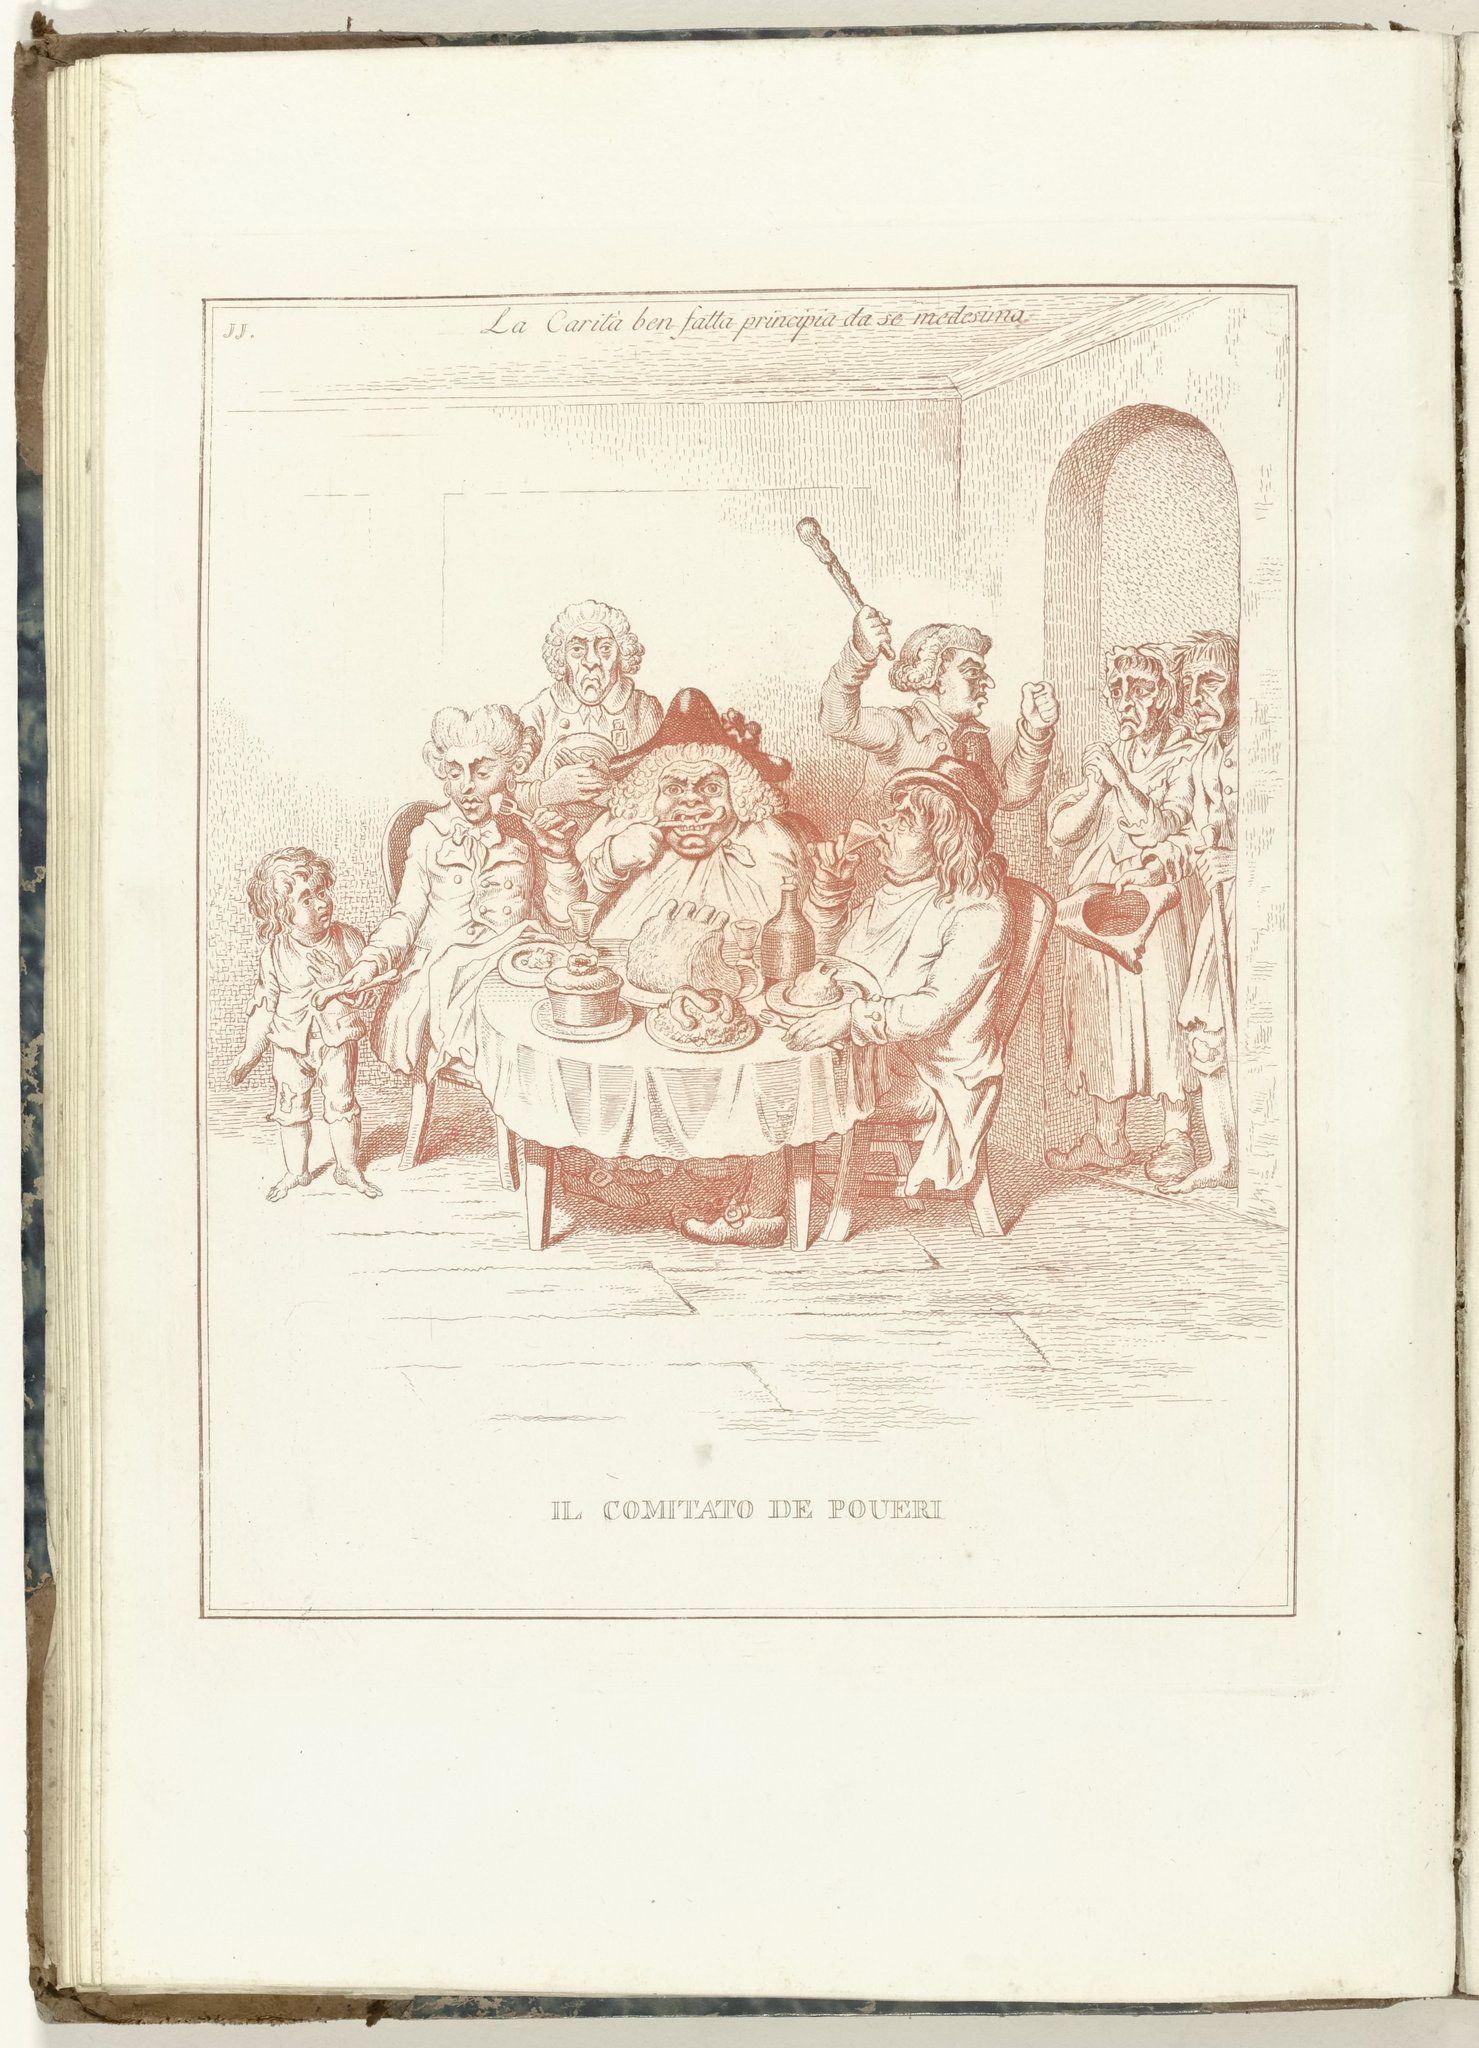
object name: print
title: Comité voor Noodlijdenden, 1795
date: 1799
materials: paper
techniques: engraving, etching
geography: venice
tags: celebration meal, feast, banquet, beggar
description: Titelpagina voor de in boekvorm uitgegeven serie van twintig spotprenten op de Provisionele Representanten van het Volk van Holland en de Bataafse Republiek in het algemeen in het jaar 1795. Kopieën gemaakt en uitgegeven in Ventië in 1799, Elke prent wordt gevolgd door een tekstblad met een verklaring in het Frans en de vertaling in het Italiaans gevolgd door een opmerking door de vertaler. Naar de oorspronkelijke reeks met de serietitel 'Hollandia Regenerata' met 20 prenten waarschijnlijk door James Gillray geëtst en waarschijnlijk uitgegeven in Londen door William Humphrey in 1795.